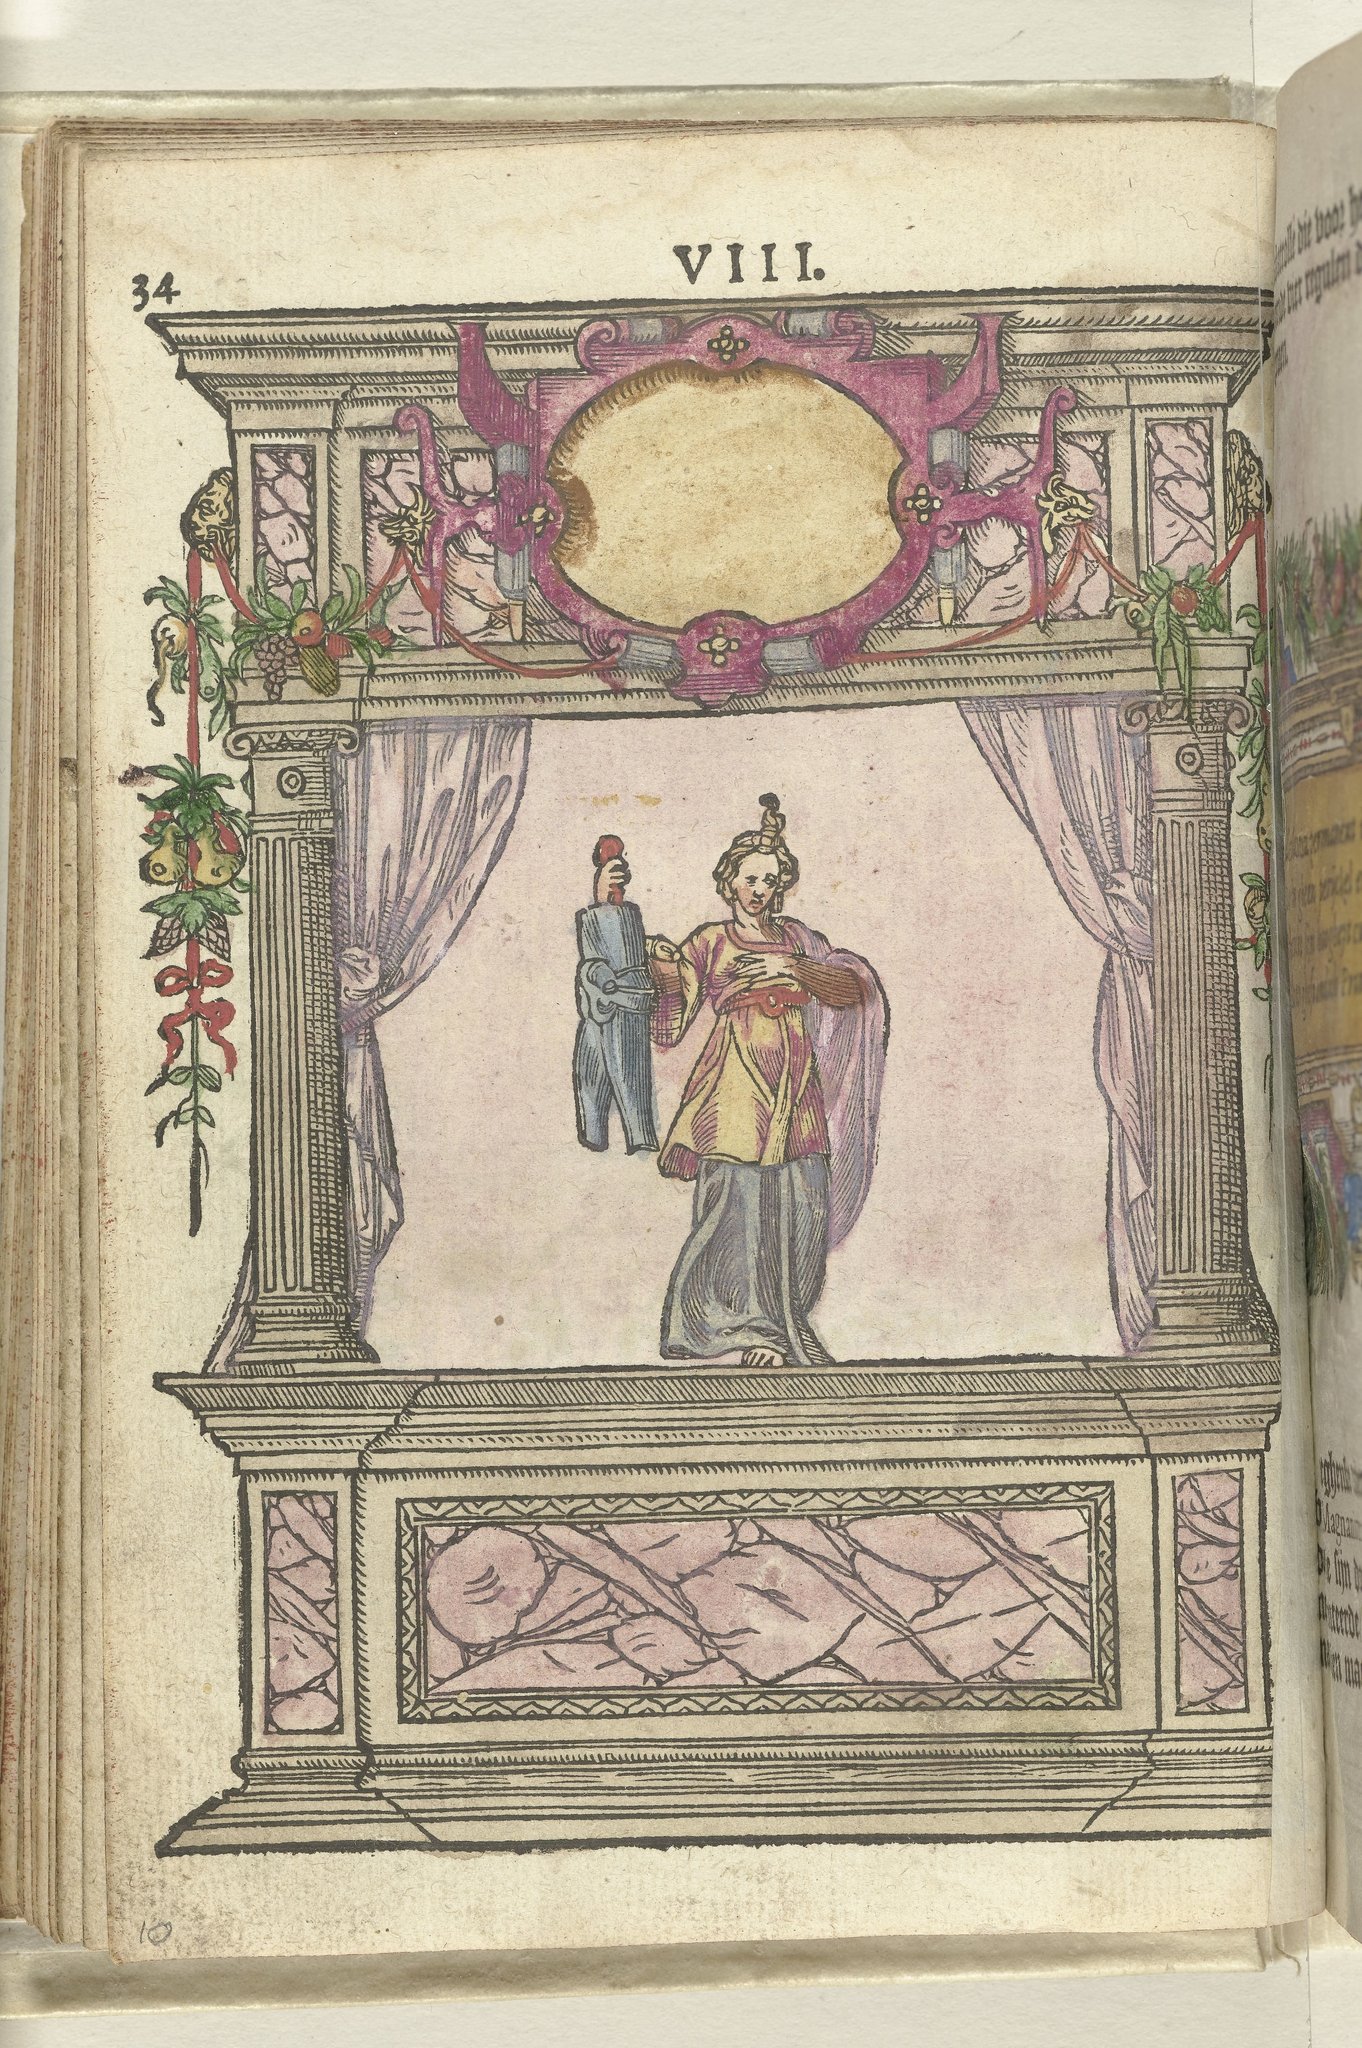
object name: print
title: Toneel met personificatie van de Standvastigheid (Constantia), 1578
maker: antoni van leest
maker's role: print maker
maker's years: 1545-1592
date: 1578-1579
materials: paper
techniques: hand coloring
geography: antwerp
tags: vienna, matthias van oostenrijk (rooms-duits keizer), group of actors, troupe; actors on the stage, triumphal entry and public reception, pageant, 'entrée solennelle', 'joyeuse entrée', constancy, tenacity; 'costanza', 'tenacità' (ripa), brussels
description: Illustratie in: J.B. Houwaert, Sommare beschrijvinghe vade triumphelijcke Incomst van den doorluchtighen ende hooghgheboren /Aerts-hertoge Matthias binnen die Prinelijcke stadt van Brussele, in 't iaer ons Heeren 1578 den XVIII dach Januarij... Gheinventeert ende ghecomponeert deur Jean Baptista Houwaert, Christoffel Plantijn, Antwerpen 1579. Boek in de Rijksmuseum Research Library met signatuur: 327 K 2.